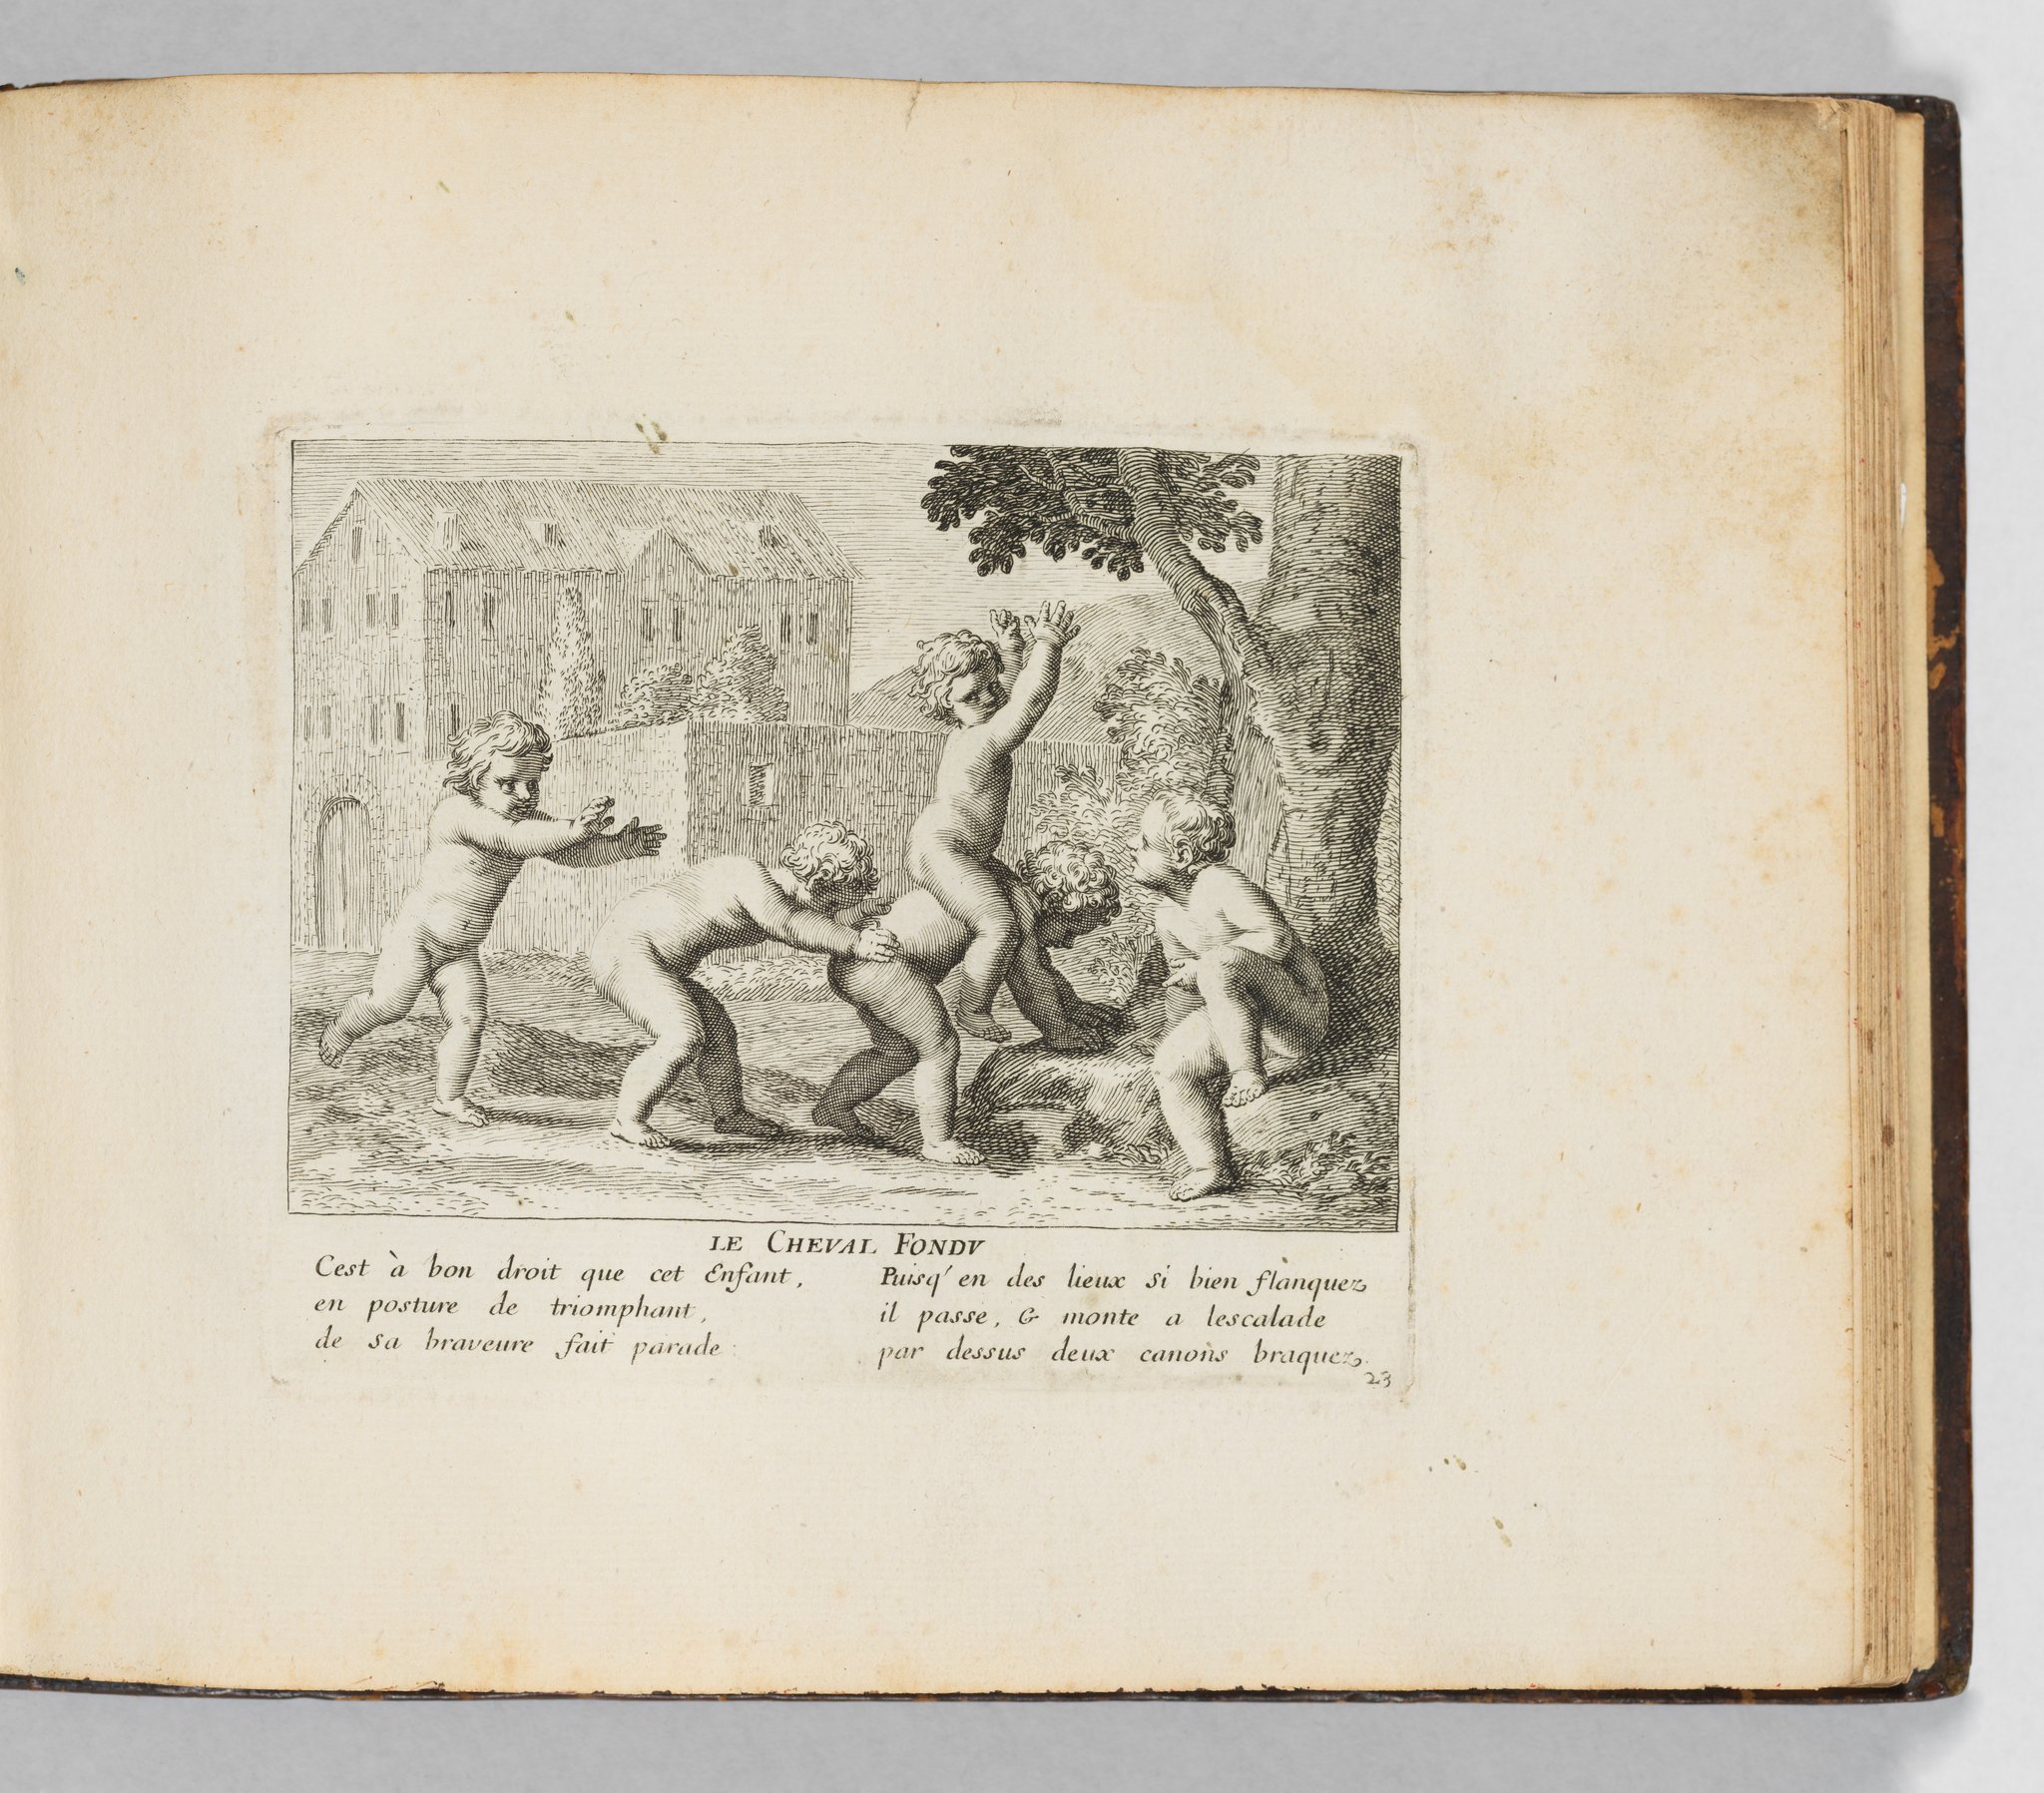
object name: book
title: Les jeux et plaisirs de l'enfance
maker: jacques stella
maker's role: designer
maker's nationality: french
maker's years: 1596-1657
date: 1657